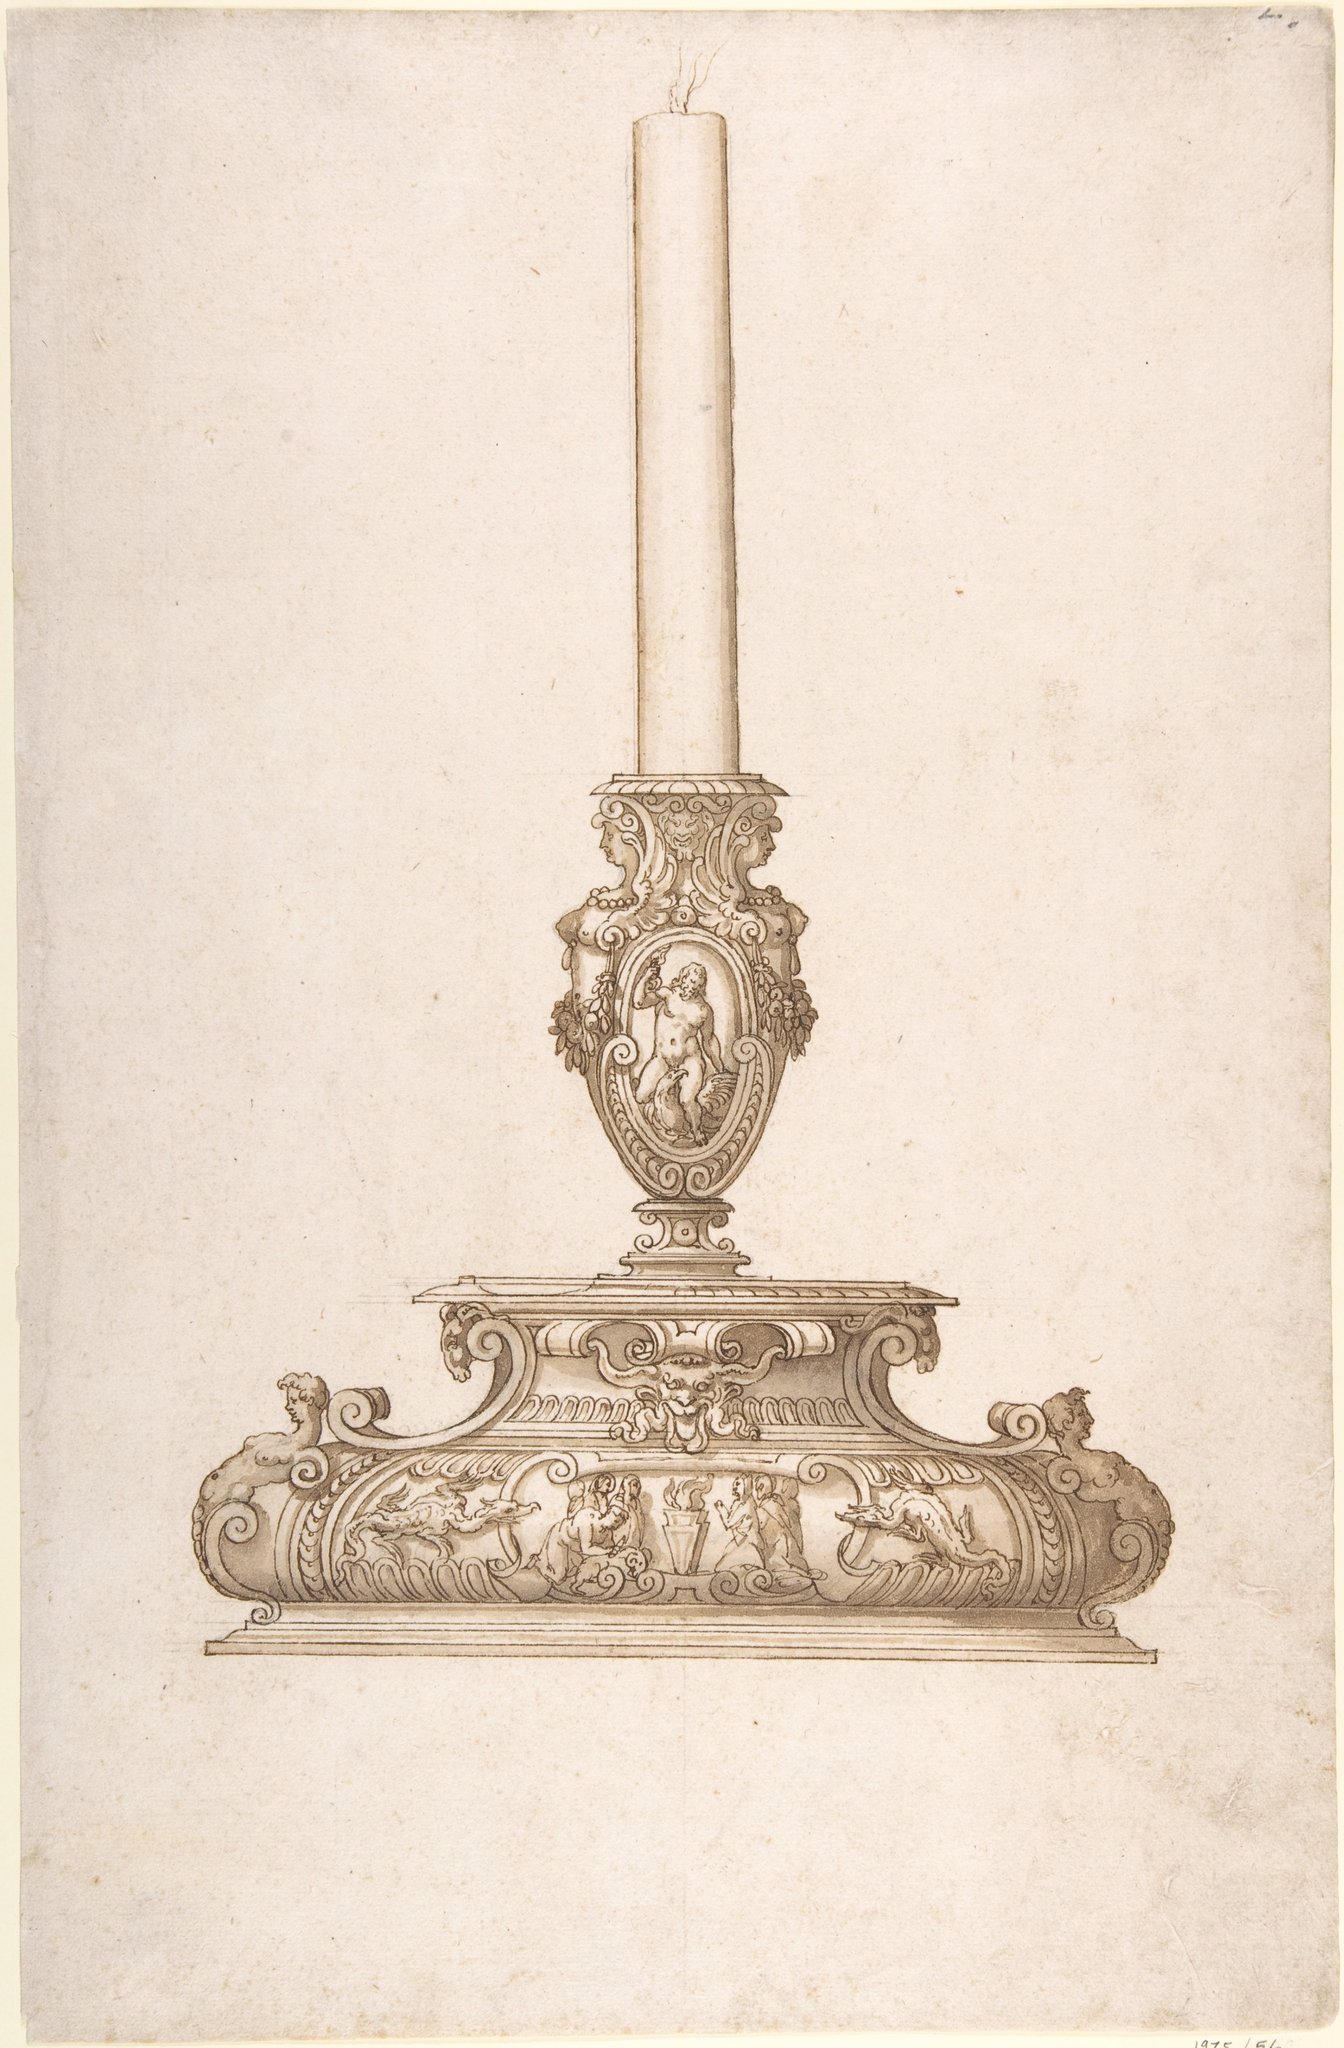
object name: drawing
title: Design for a Candlestick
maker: ottavio strada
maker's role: artist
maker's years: 1550-1606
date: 1510-1563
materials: chalk, ink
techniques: brush, pen, wash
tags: candlesticks